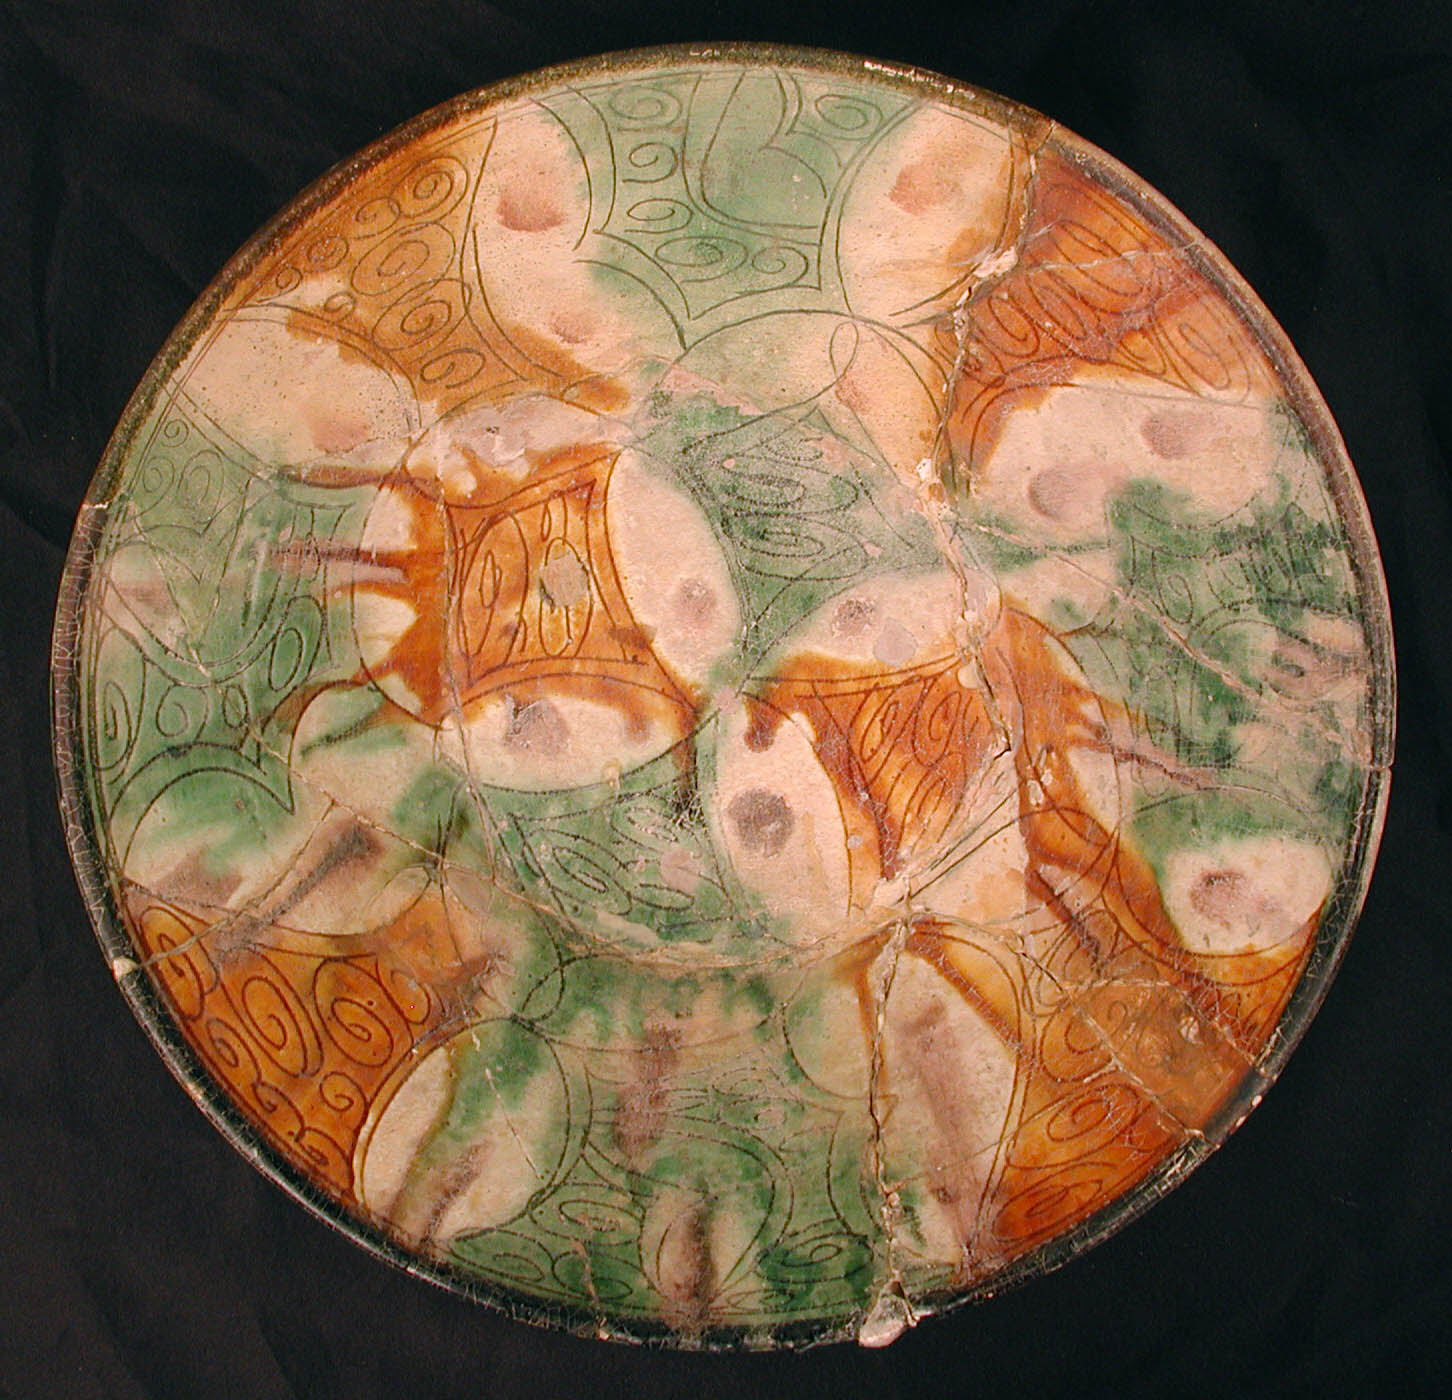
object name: bowl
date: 801-900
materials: earthenware, glaze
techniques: incising, polychrome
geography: iran